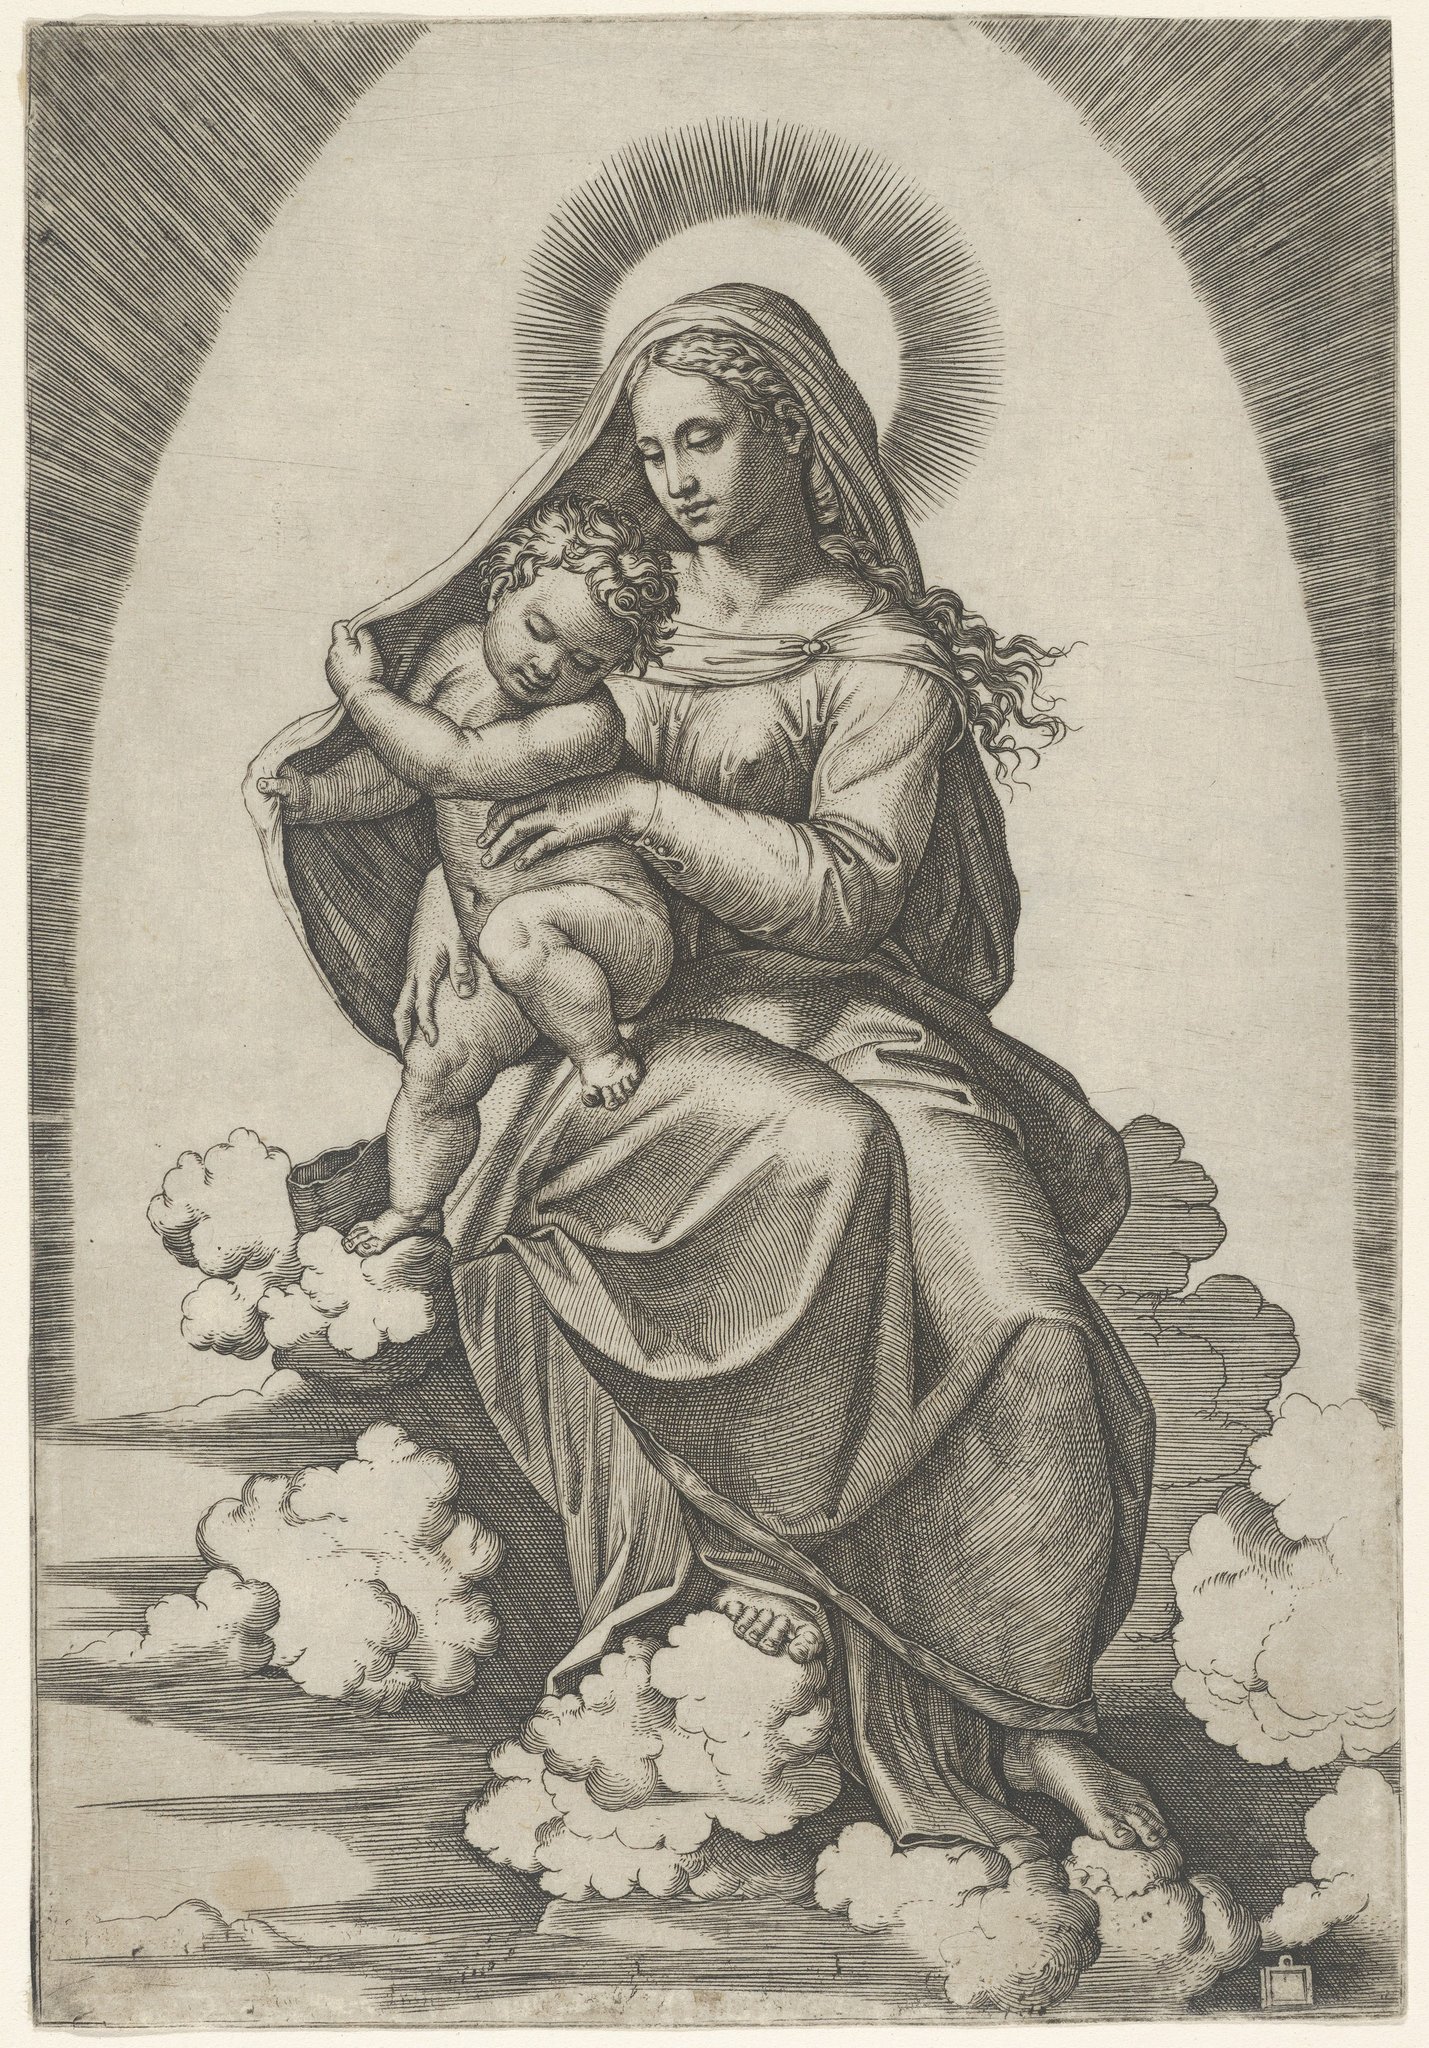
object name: print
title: Madonna and Child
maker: marcantonio raimondi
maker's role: artist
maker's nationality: italian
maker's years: 1475-1534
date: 1512-1516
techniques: engraving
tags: madonna and child